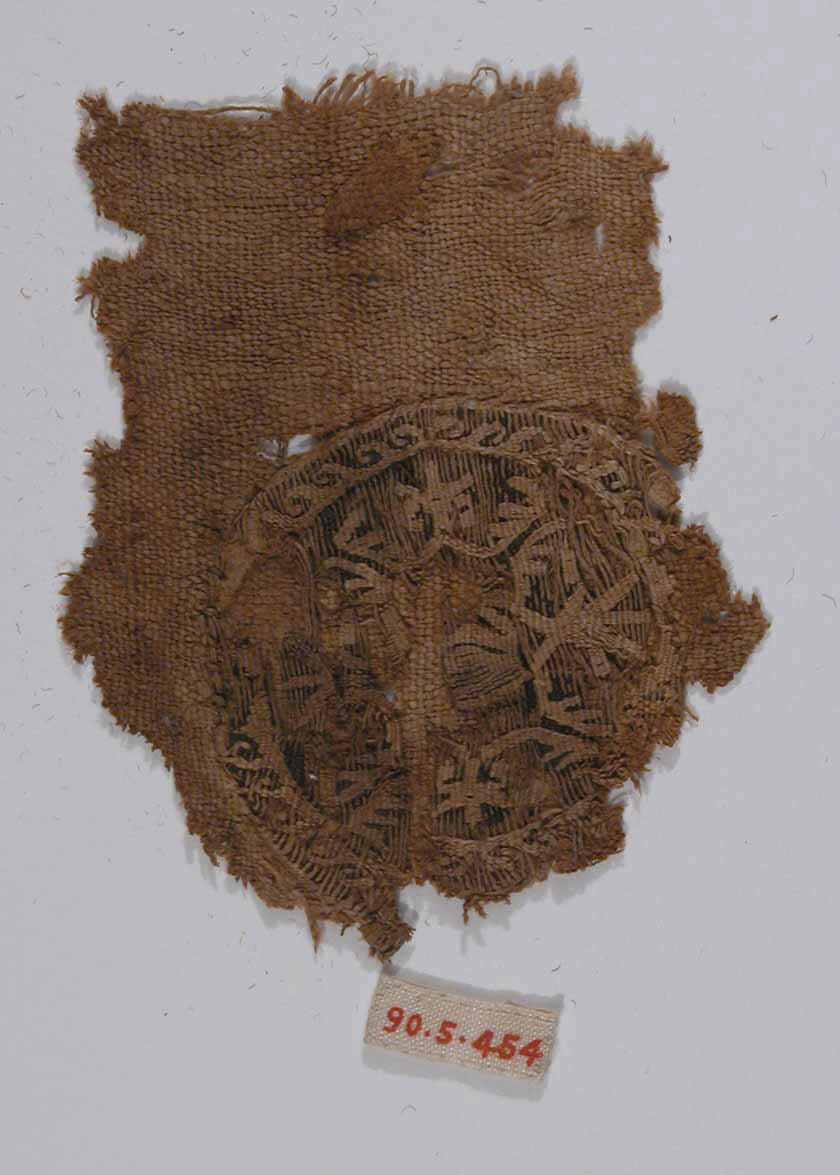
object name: textile fragment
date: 401-500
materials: linen, wool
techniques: weave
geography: egypt